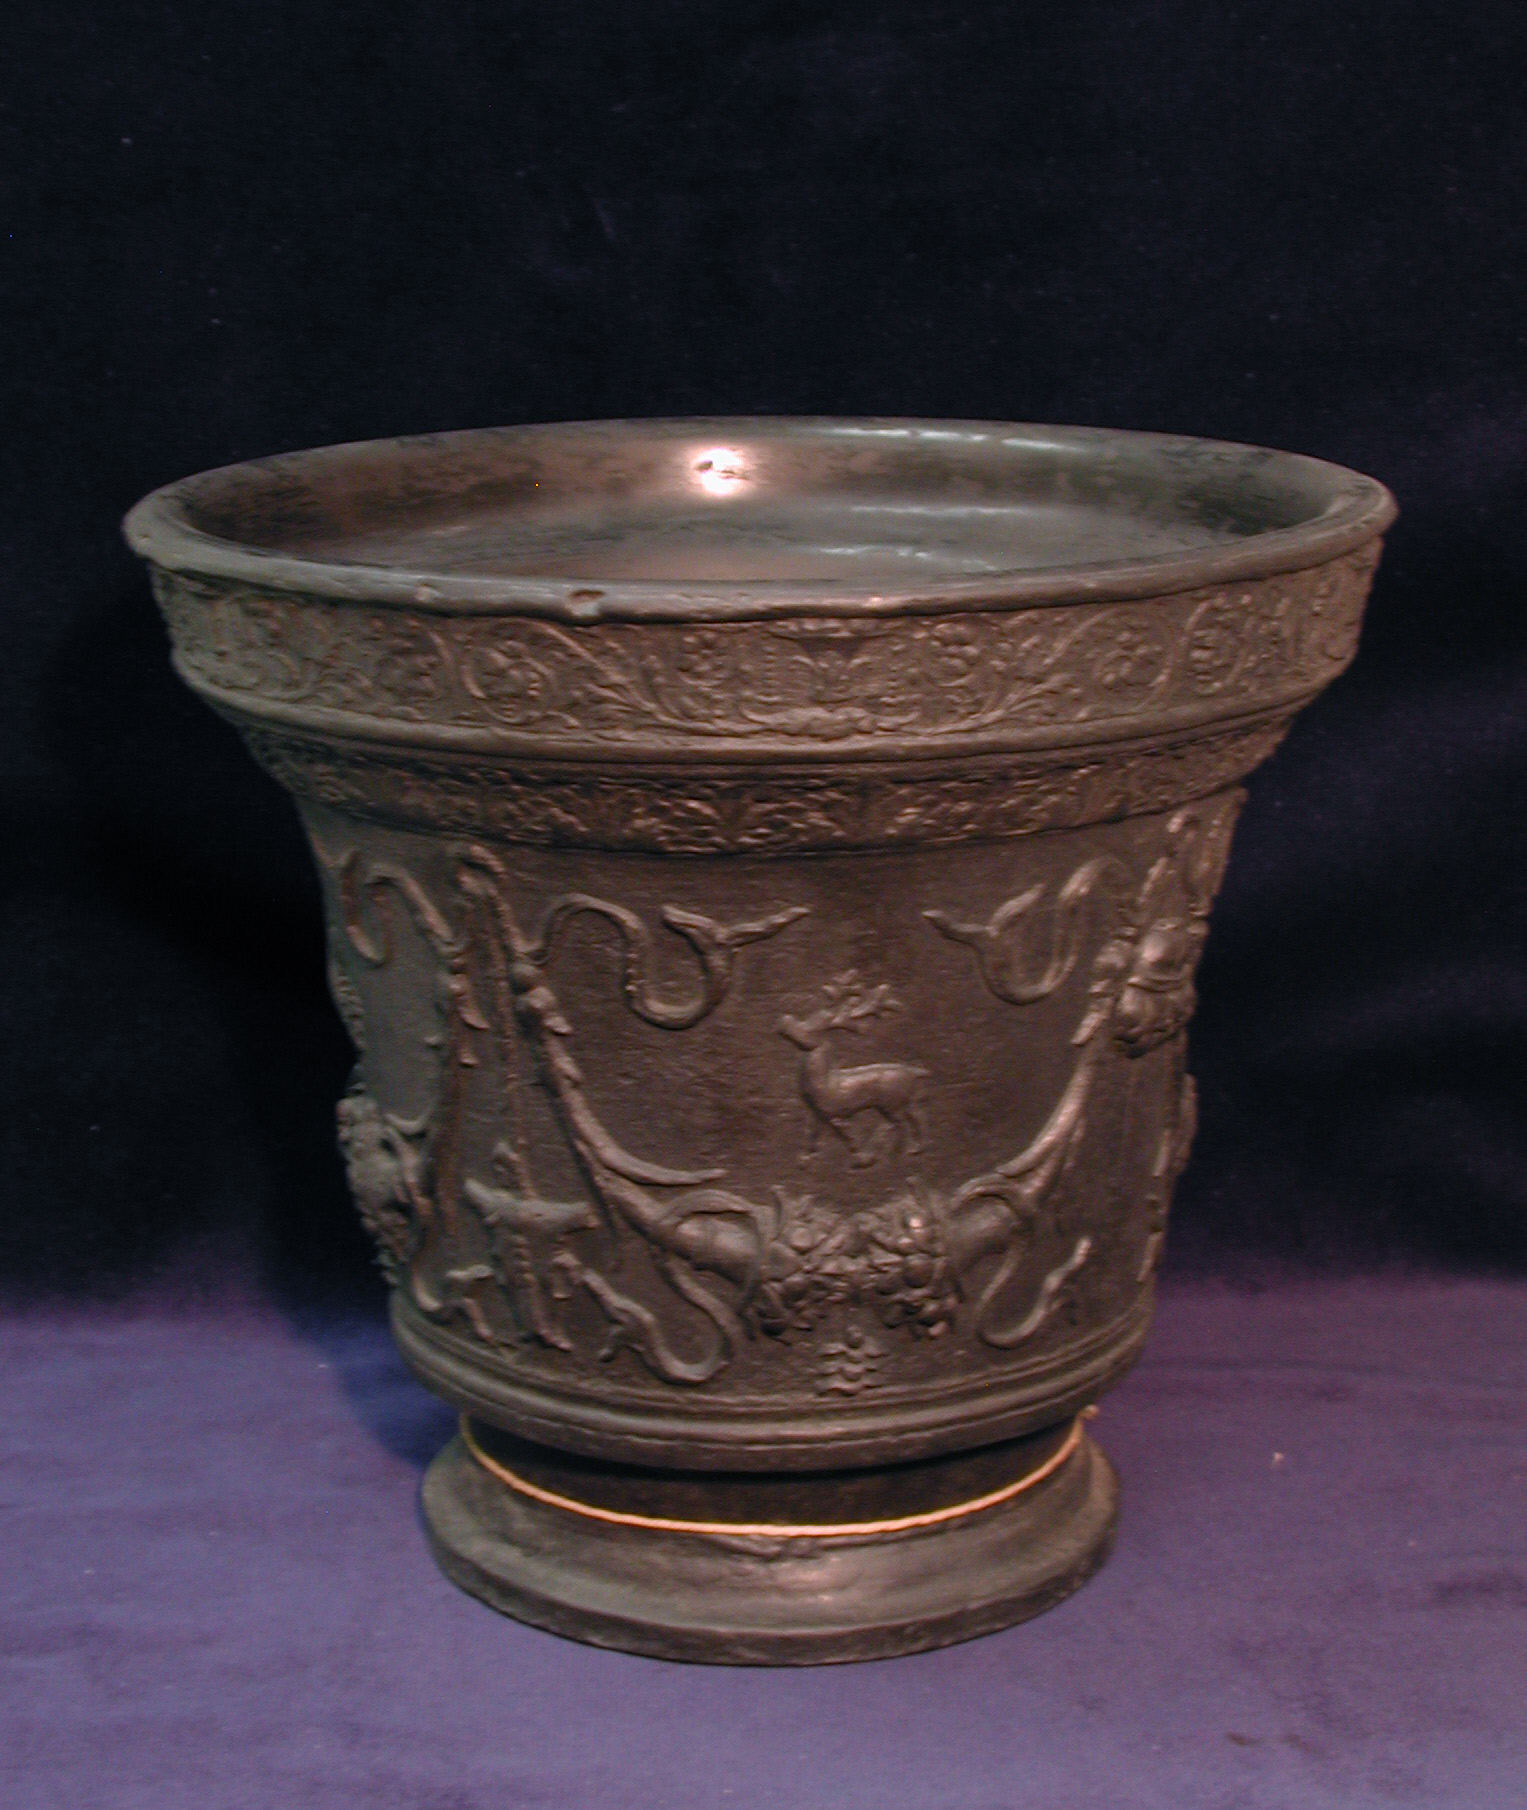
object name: mortar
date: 1801-1900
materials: bronze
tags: deer